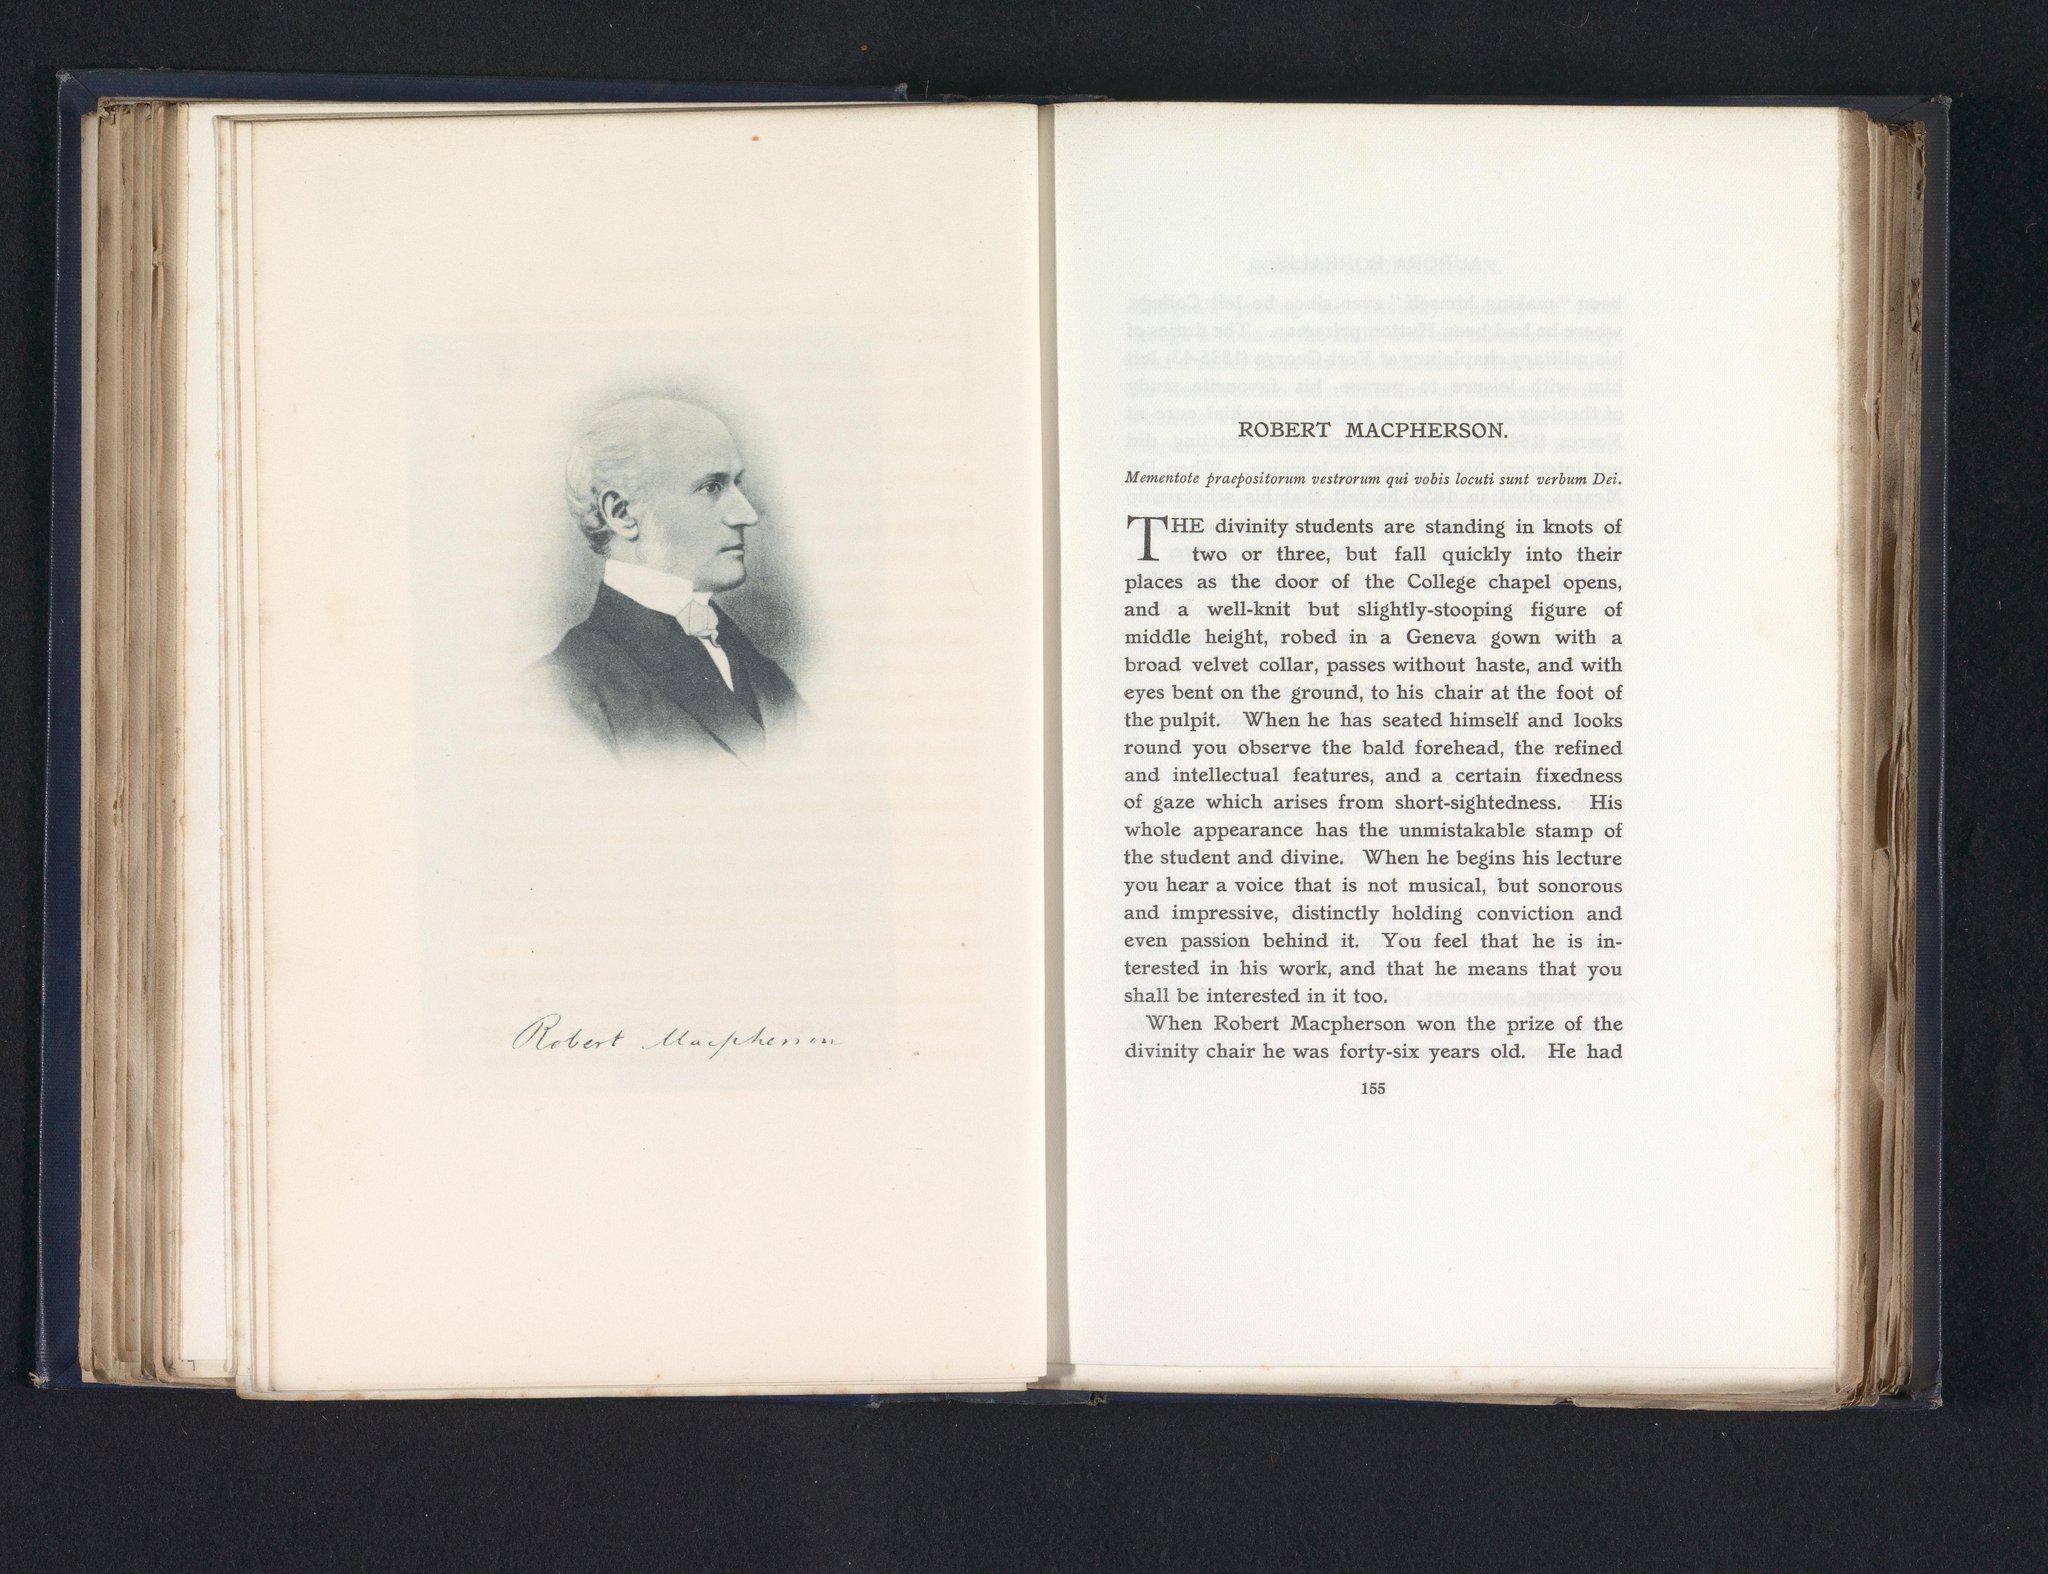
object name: page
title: Robert Macpherson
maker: Anonymous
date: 1889-1899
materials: paper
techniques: photograph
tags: scholar, philosopher